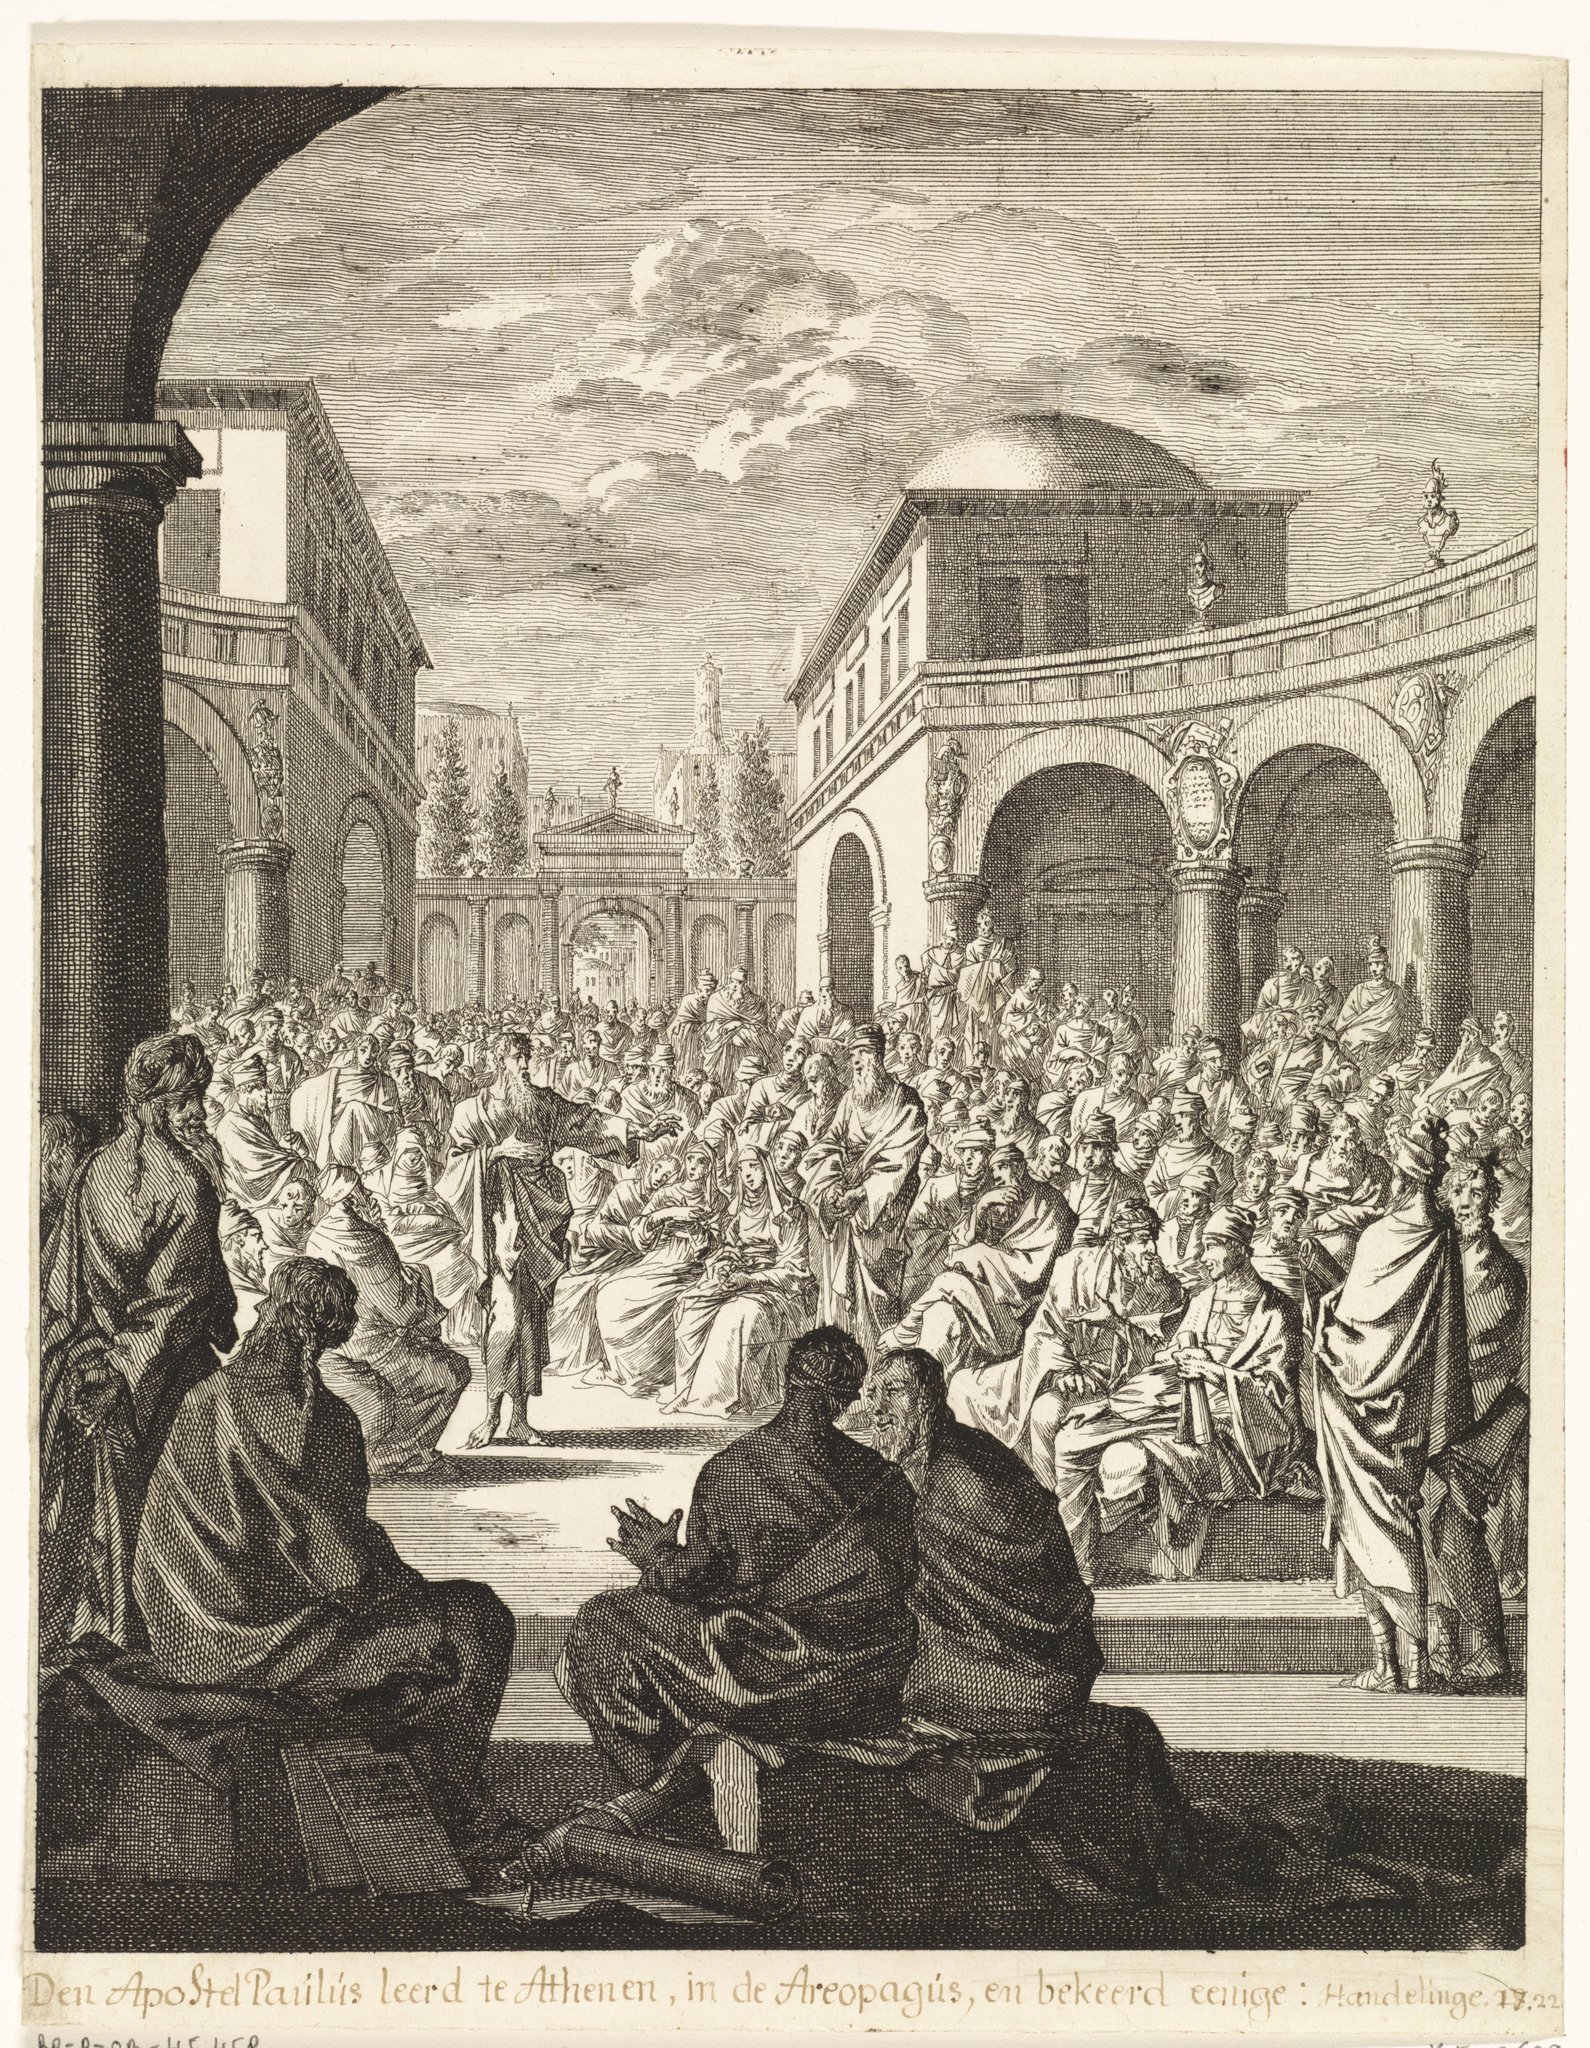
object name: print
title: Paulus voor de leden van de Areopagus in Athene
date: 1708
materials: paper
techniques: etching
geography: amsterdam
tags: paul in athens: on the areopagus he discusses with philosophers (in front of the temple of mars)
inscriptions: collector's mark: Lugt 2228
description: Proefdruk van een prent welke is opgenomen als illustratie in: Historiae Celebriores Veteris Testamenti. Christoph Weigel, 1708.